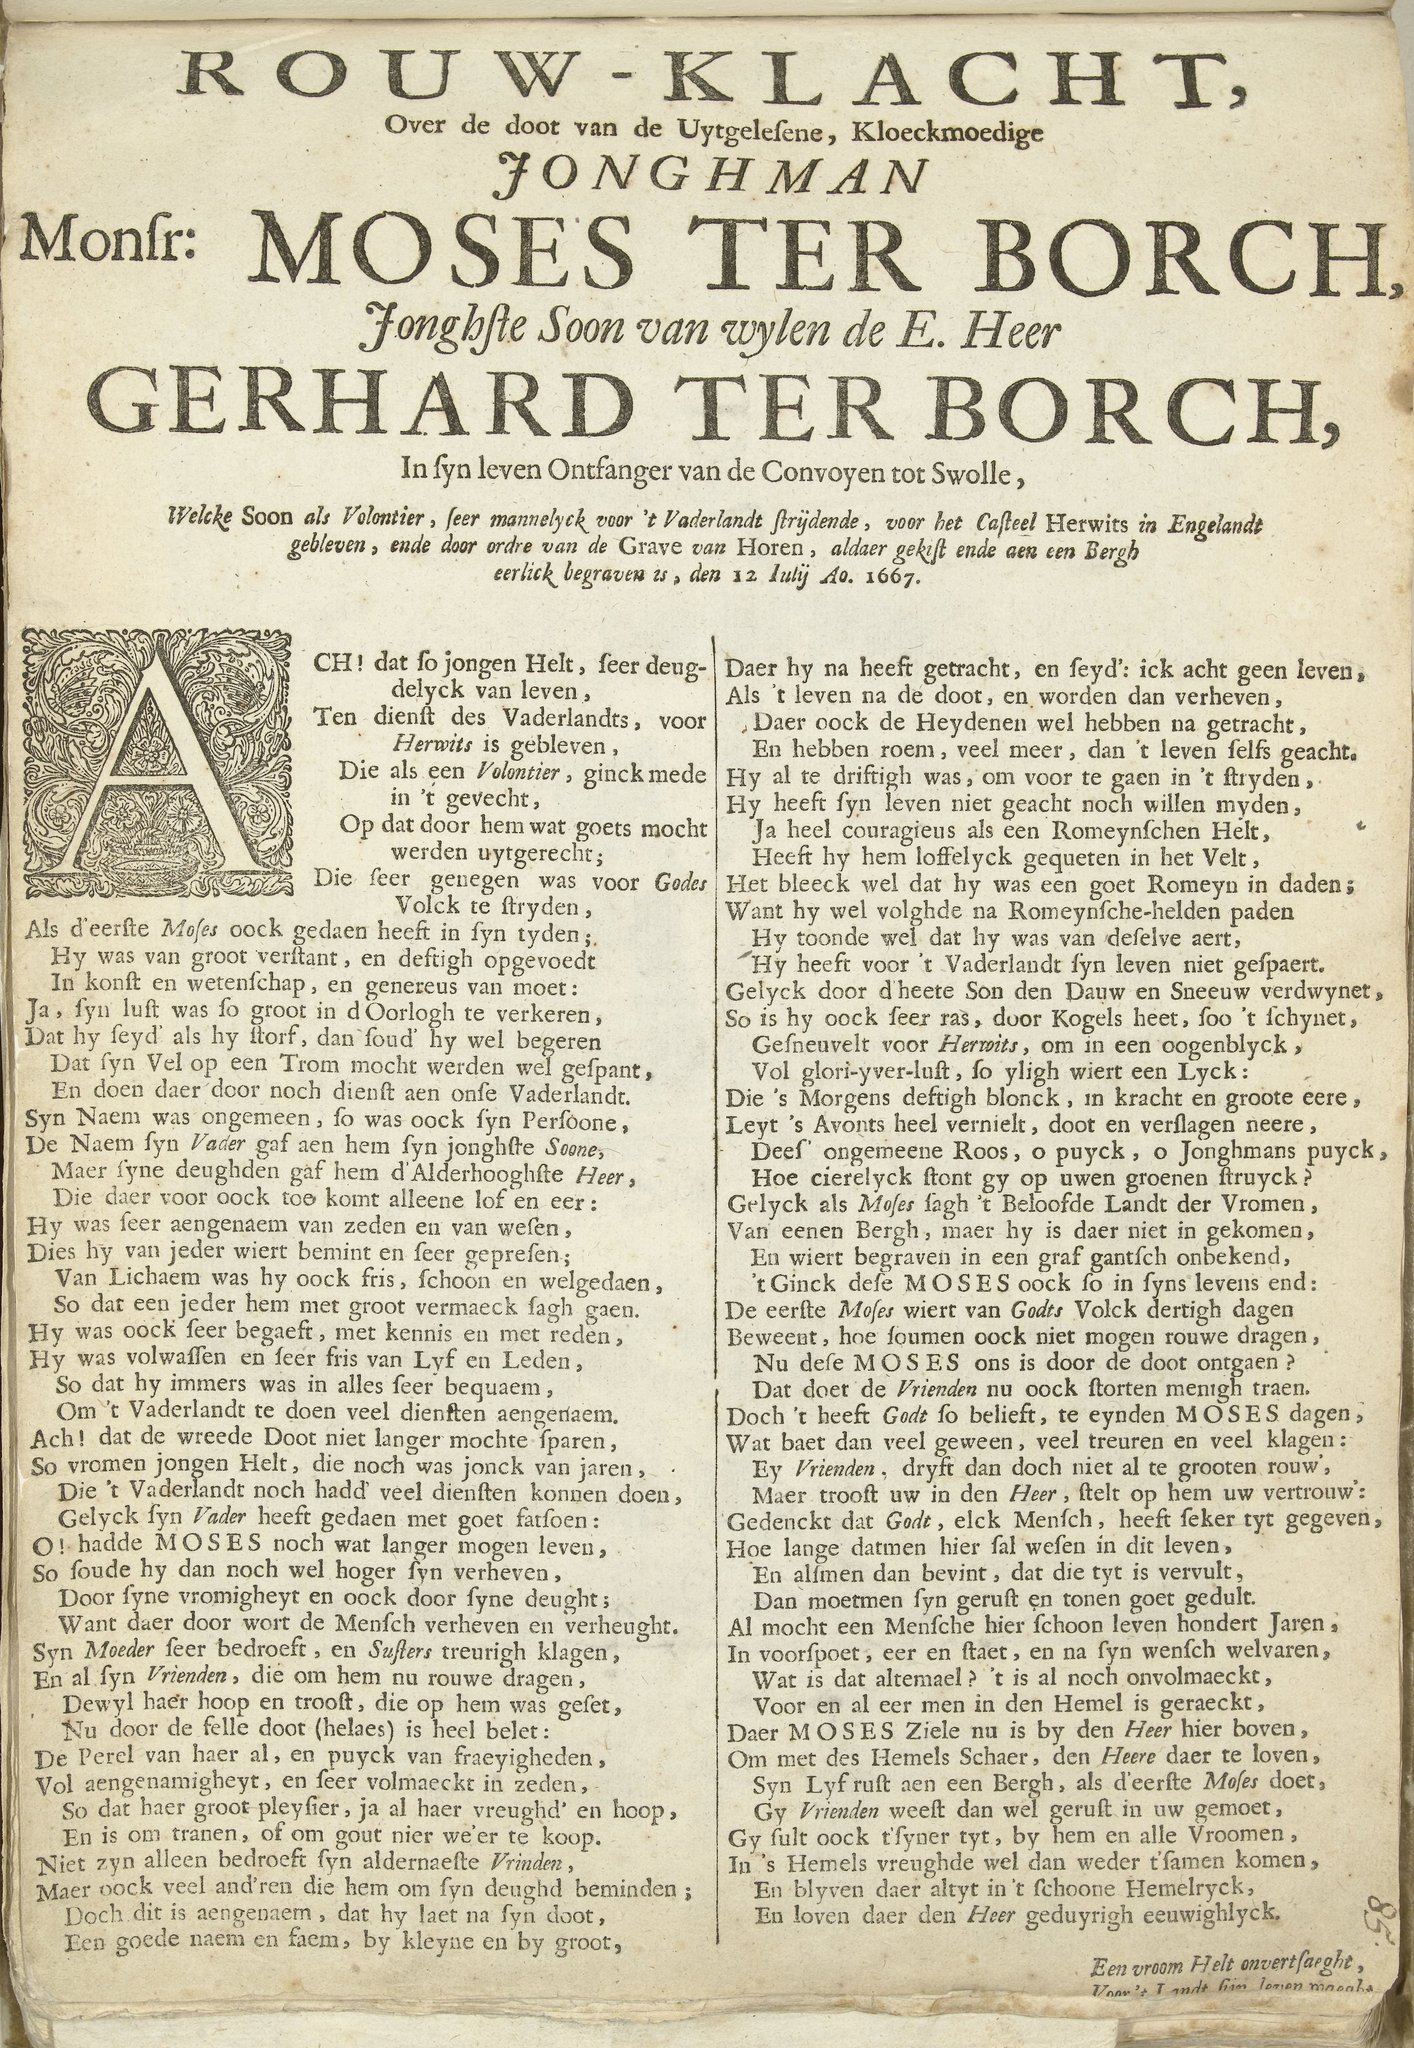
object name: printed matter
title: Rouw-Klacht, over de doot van de uytgelesene, kloeckmoedige jonghman Monsr. Moses Ter Borch, (...)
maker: Anonymous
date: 1667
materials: paper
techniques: letterpress printing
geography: netherlands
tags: draughtsman, moses ter borch, raid on the medway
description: Gepubliceerd rouwgedicht, hoogstwaarschijnlijk niet door een amateur als Sijbrant Schellinger opgesteld maar door een professionele schrijver die geoefend was in het schrijven van dergelijke standaard gedichten.